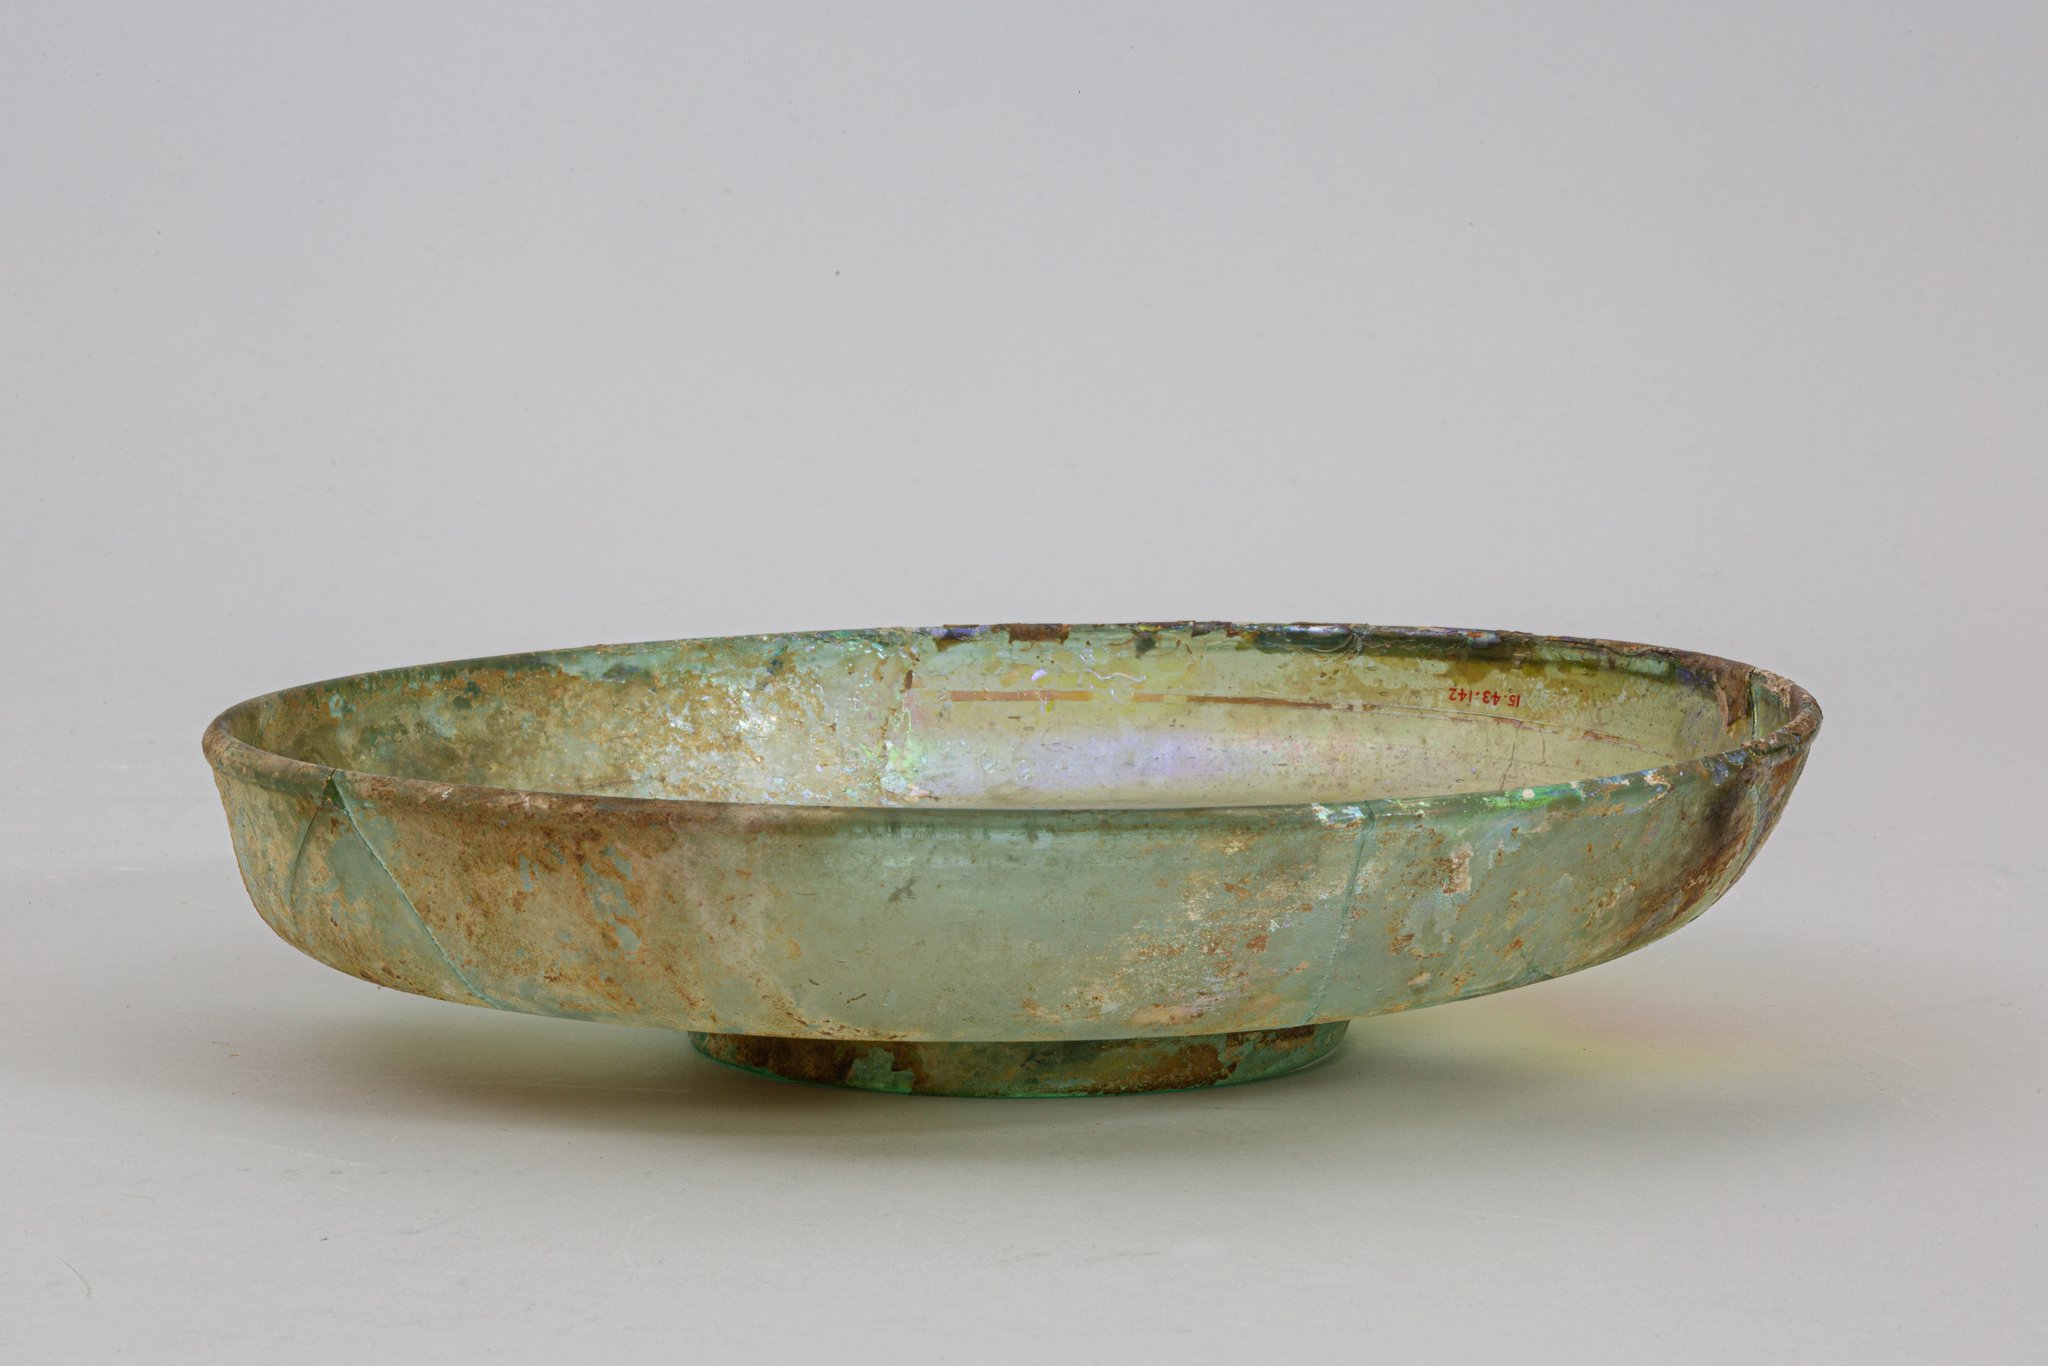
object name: dish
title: Glass dish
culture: roman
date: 201-400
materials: glass